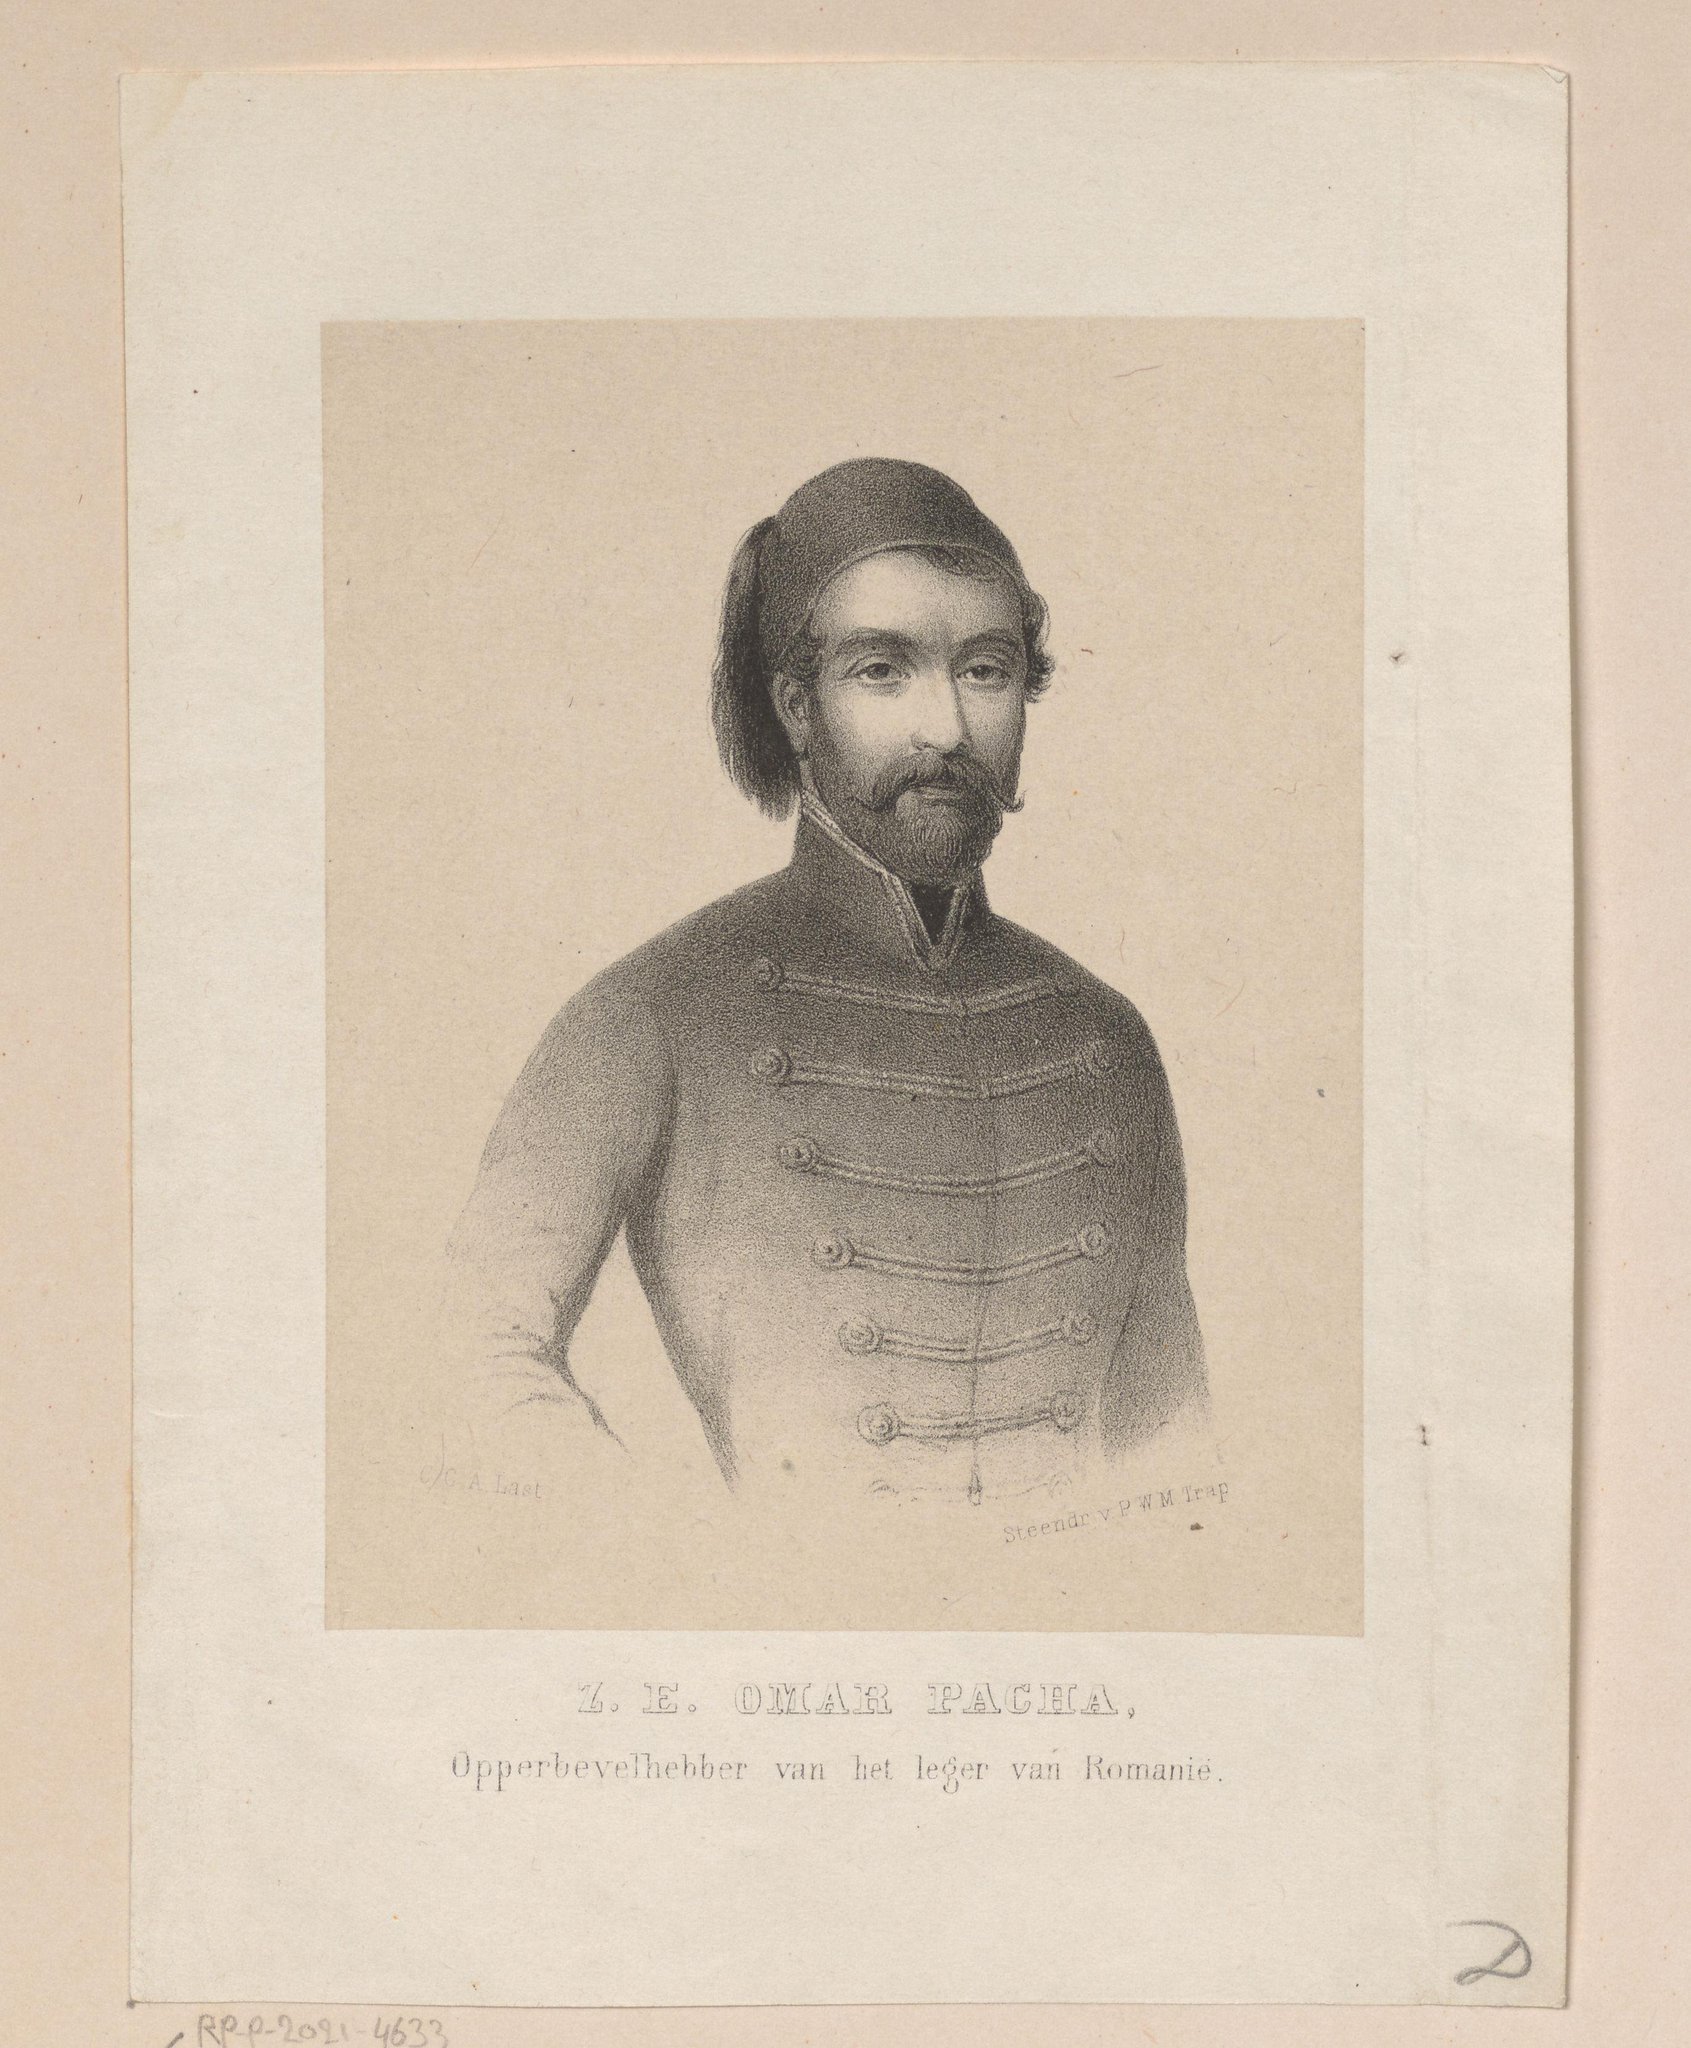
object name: print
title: Portret van Omar Pasha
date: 1836-1905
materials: paper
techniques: lithograph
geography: leiden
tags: historical persons